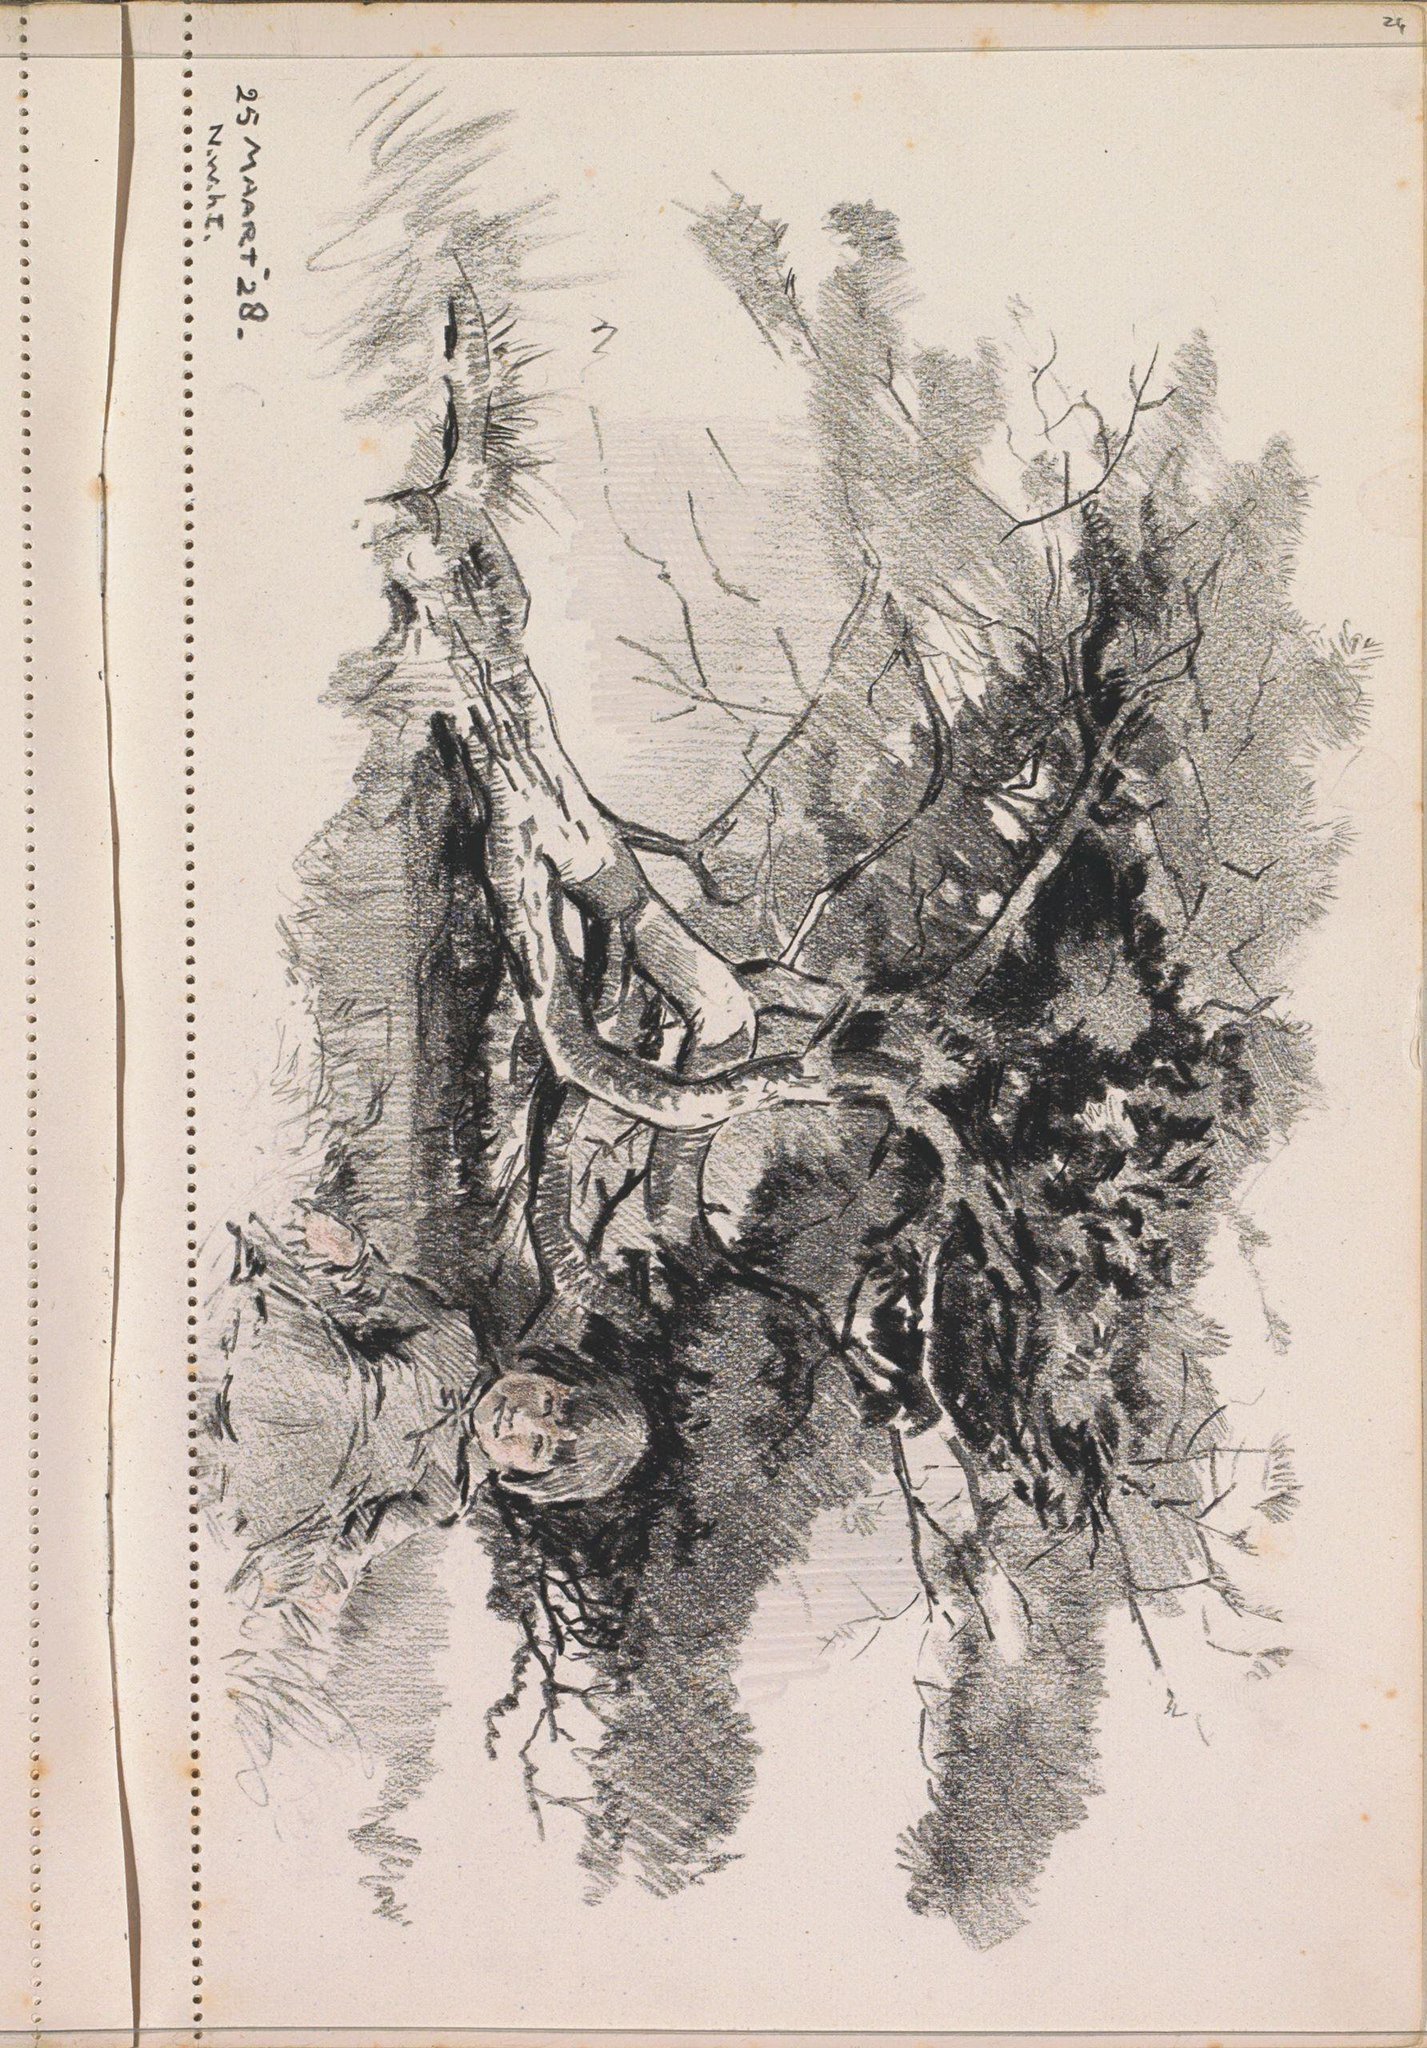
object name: sketchbook leaf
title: Liggend meisje onder een boom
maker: otto verhagen (i)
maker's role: draughtsman, print maker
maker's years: 1885-1951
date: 1903-1928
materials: chalk, paper, pencil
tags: trees, girl (child between toddler and youth)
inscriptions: date and inscription: ‘25 MAART '28/ N.W.h.I’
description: Pagina 24 uit een schetsboek met 51 bladen.